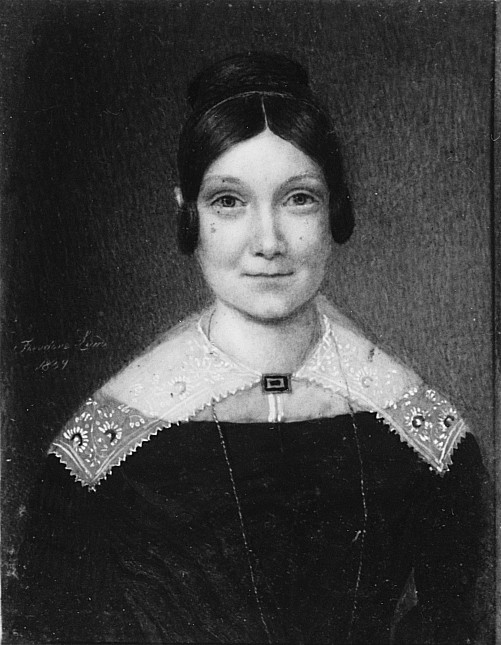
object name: painting, miniature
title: Mrs. Warren Rogers (Julie Francoise Gabrielle d'Anterroches)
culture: american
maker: theodore lund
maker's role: artist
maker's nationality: american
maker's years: 1810-1895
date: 1839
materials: ivory, watercolor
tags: portraits,women